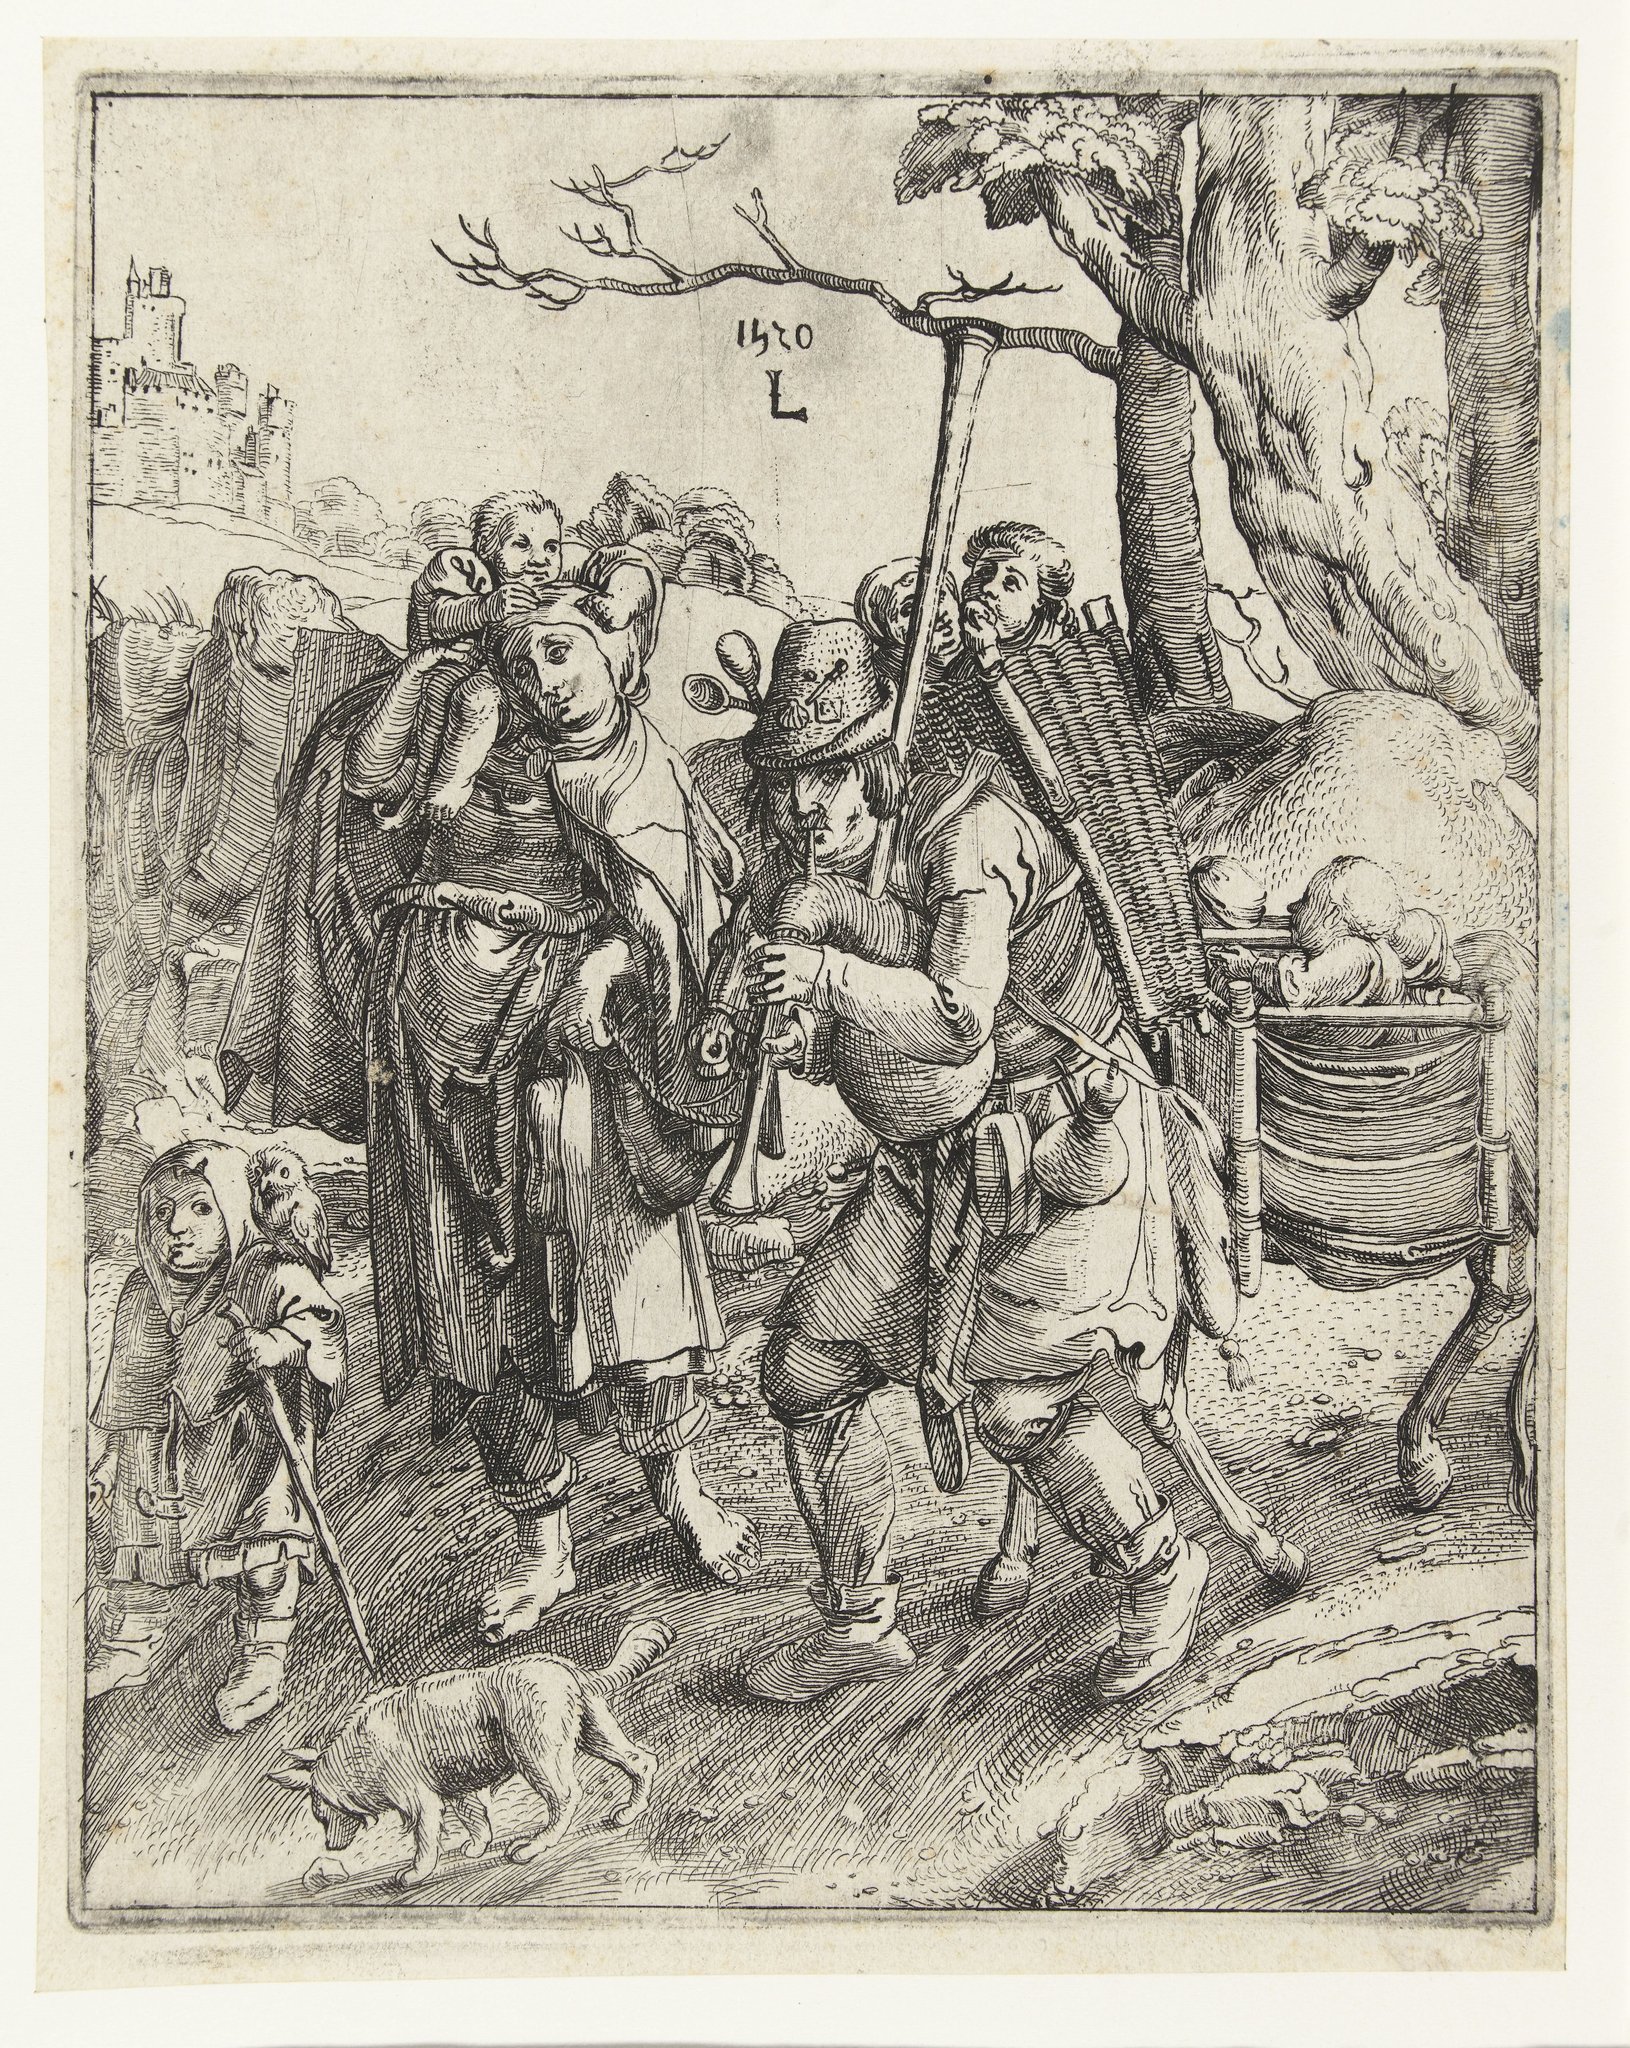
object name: print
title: Uilenspiegel: de bedelaarsfamilie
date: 1520-1583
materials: paper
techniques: etching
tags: bagpipe, musette, eulenspiegel, beggar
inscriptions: collector's mark: Lugt 240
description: Doedelzakspelende man met twee kinderen in de mand op zijn rug, naast hem een vrouw met een kind op de schouder. Zij voeren een ezel mee, beladen met kinderen. Voorop loopt een jongen met een uil op de schouder, naast hem snuffelt een hondje.